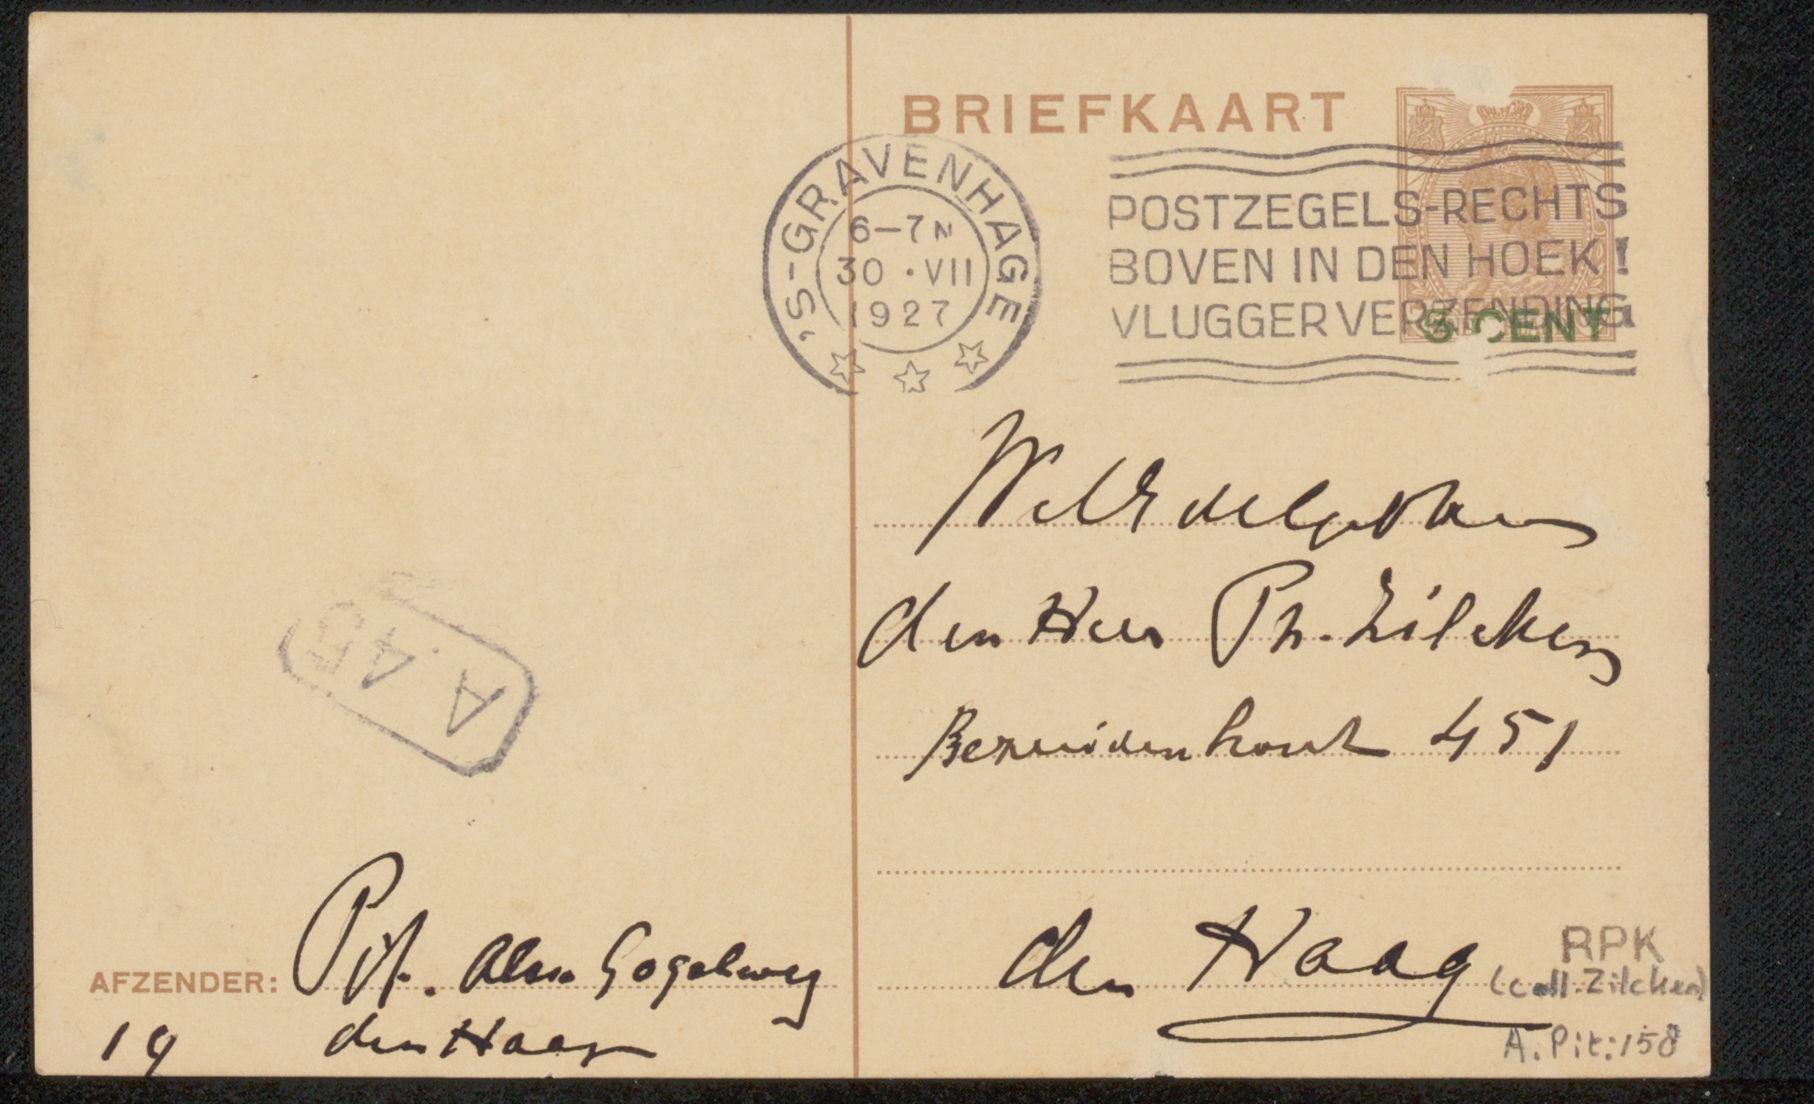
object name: postcard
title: Briefkaart aan Philip Zilcken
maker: adriaan pit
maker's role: print maker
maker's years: 1860-1944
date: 1927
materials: cardboard, ink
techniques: pen, writing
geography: the hague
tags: draughtsman, philip zilcken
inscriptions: collector's mark: ‘RPK’